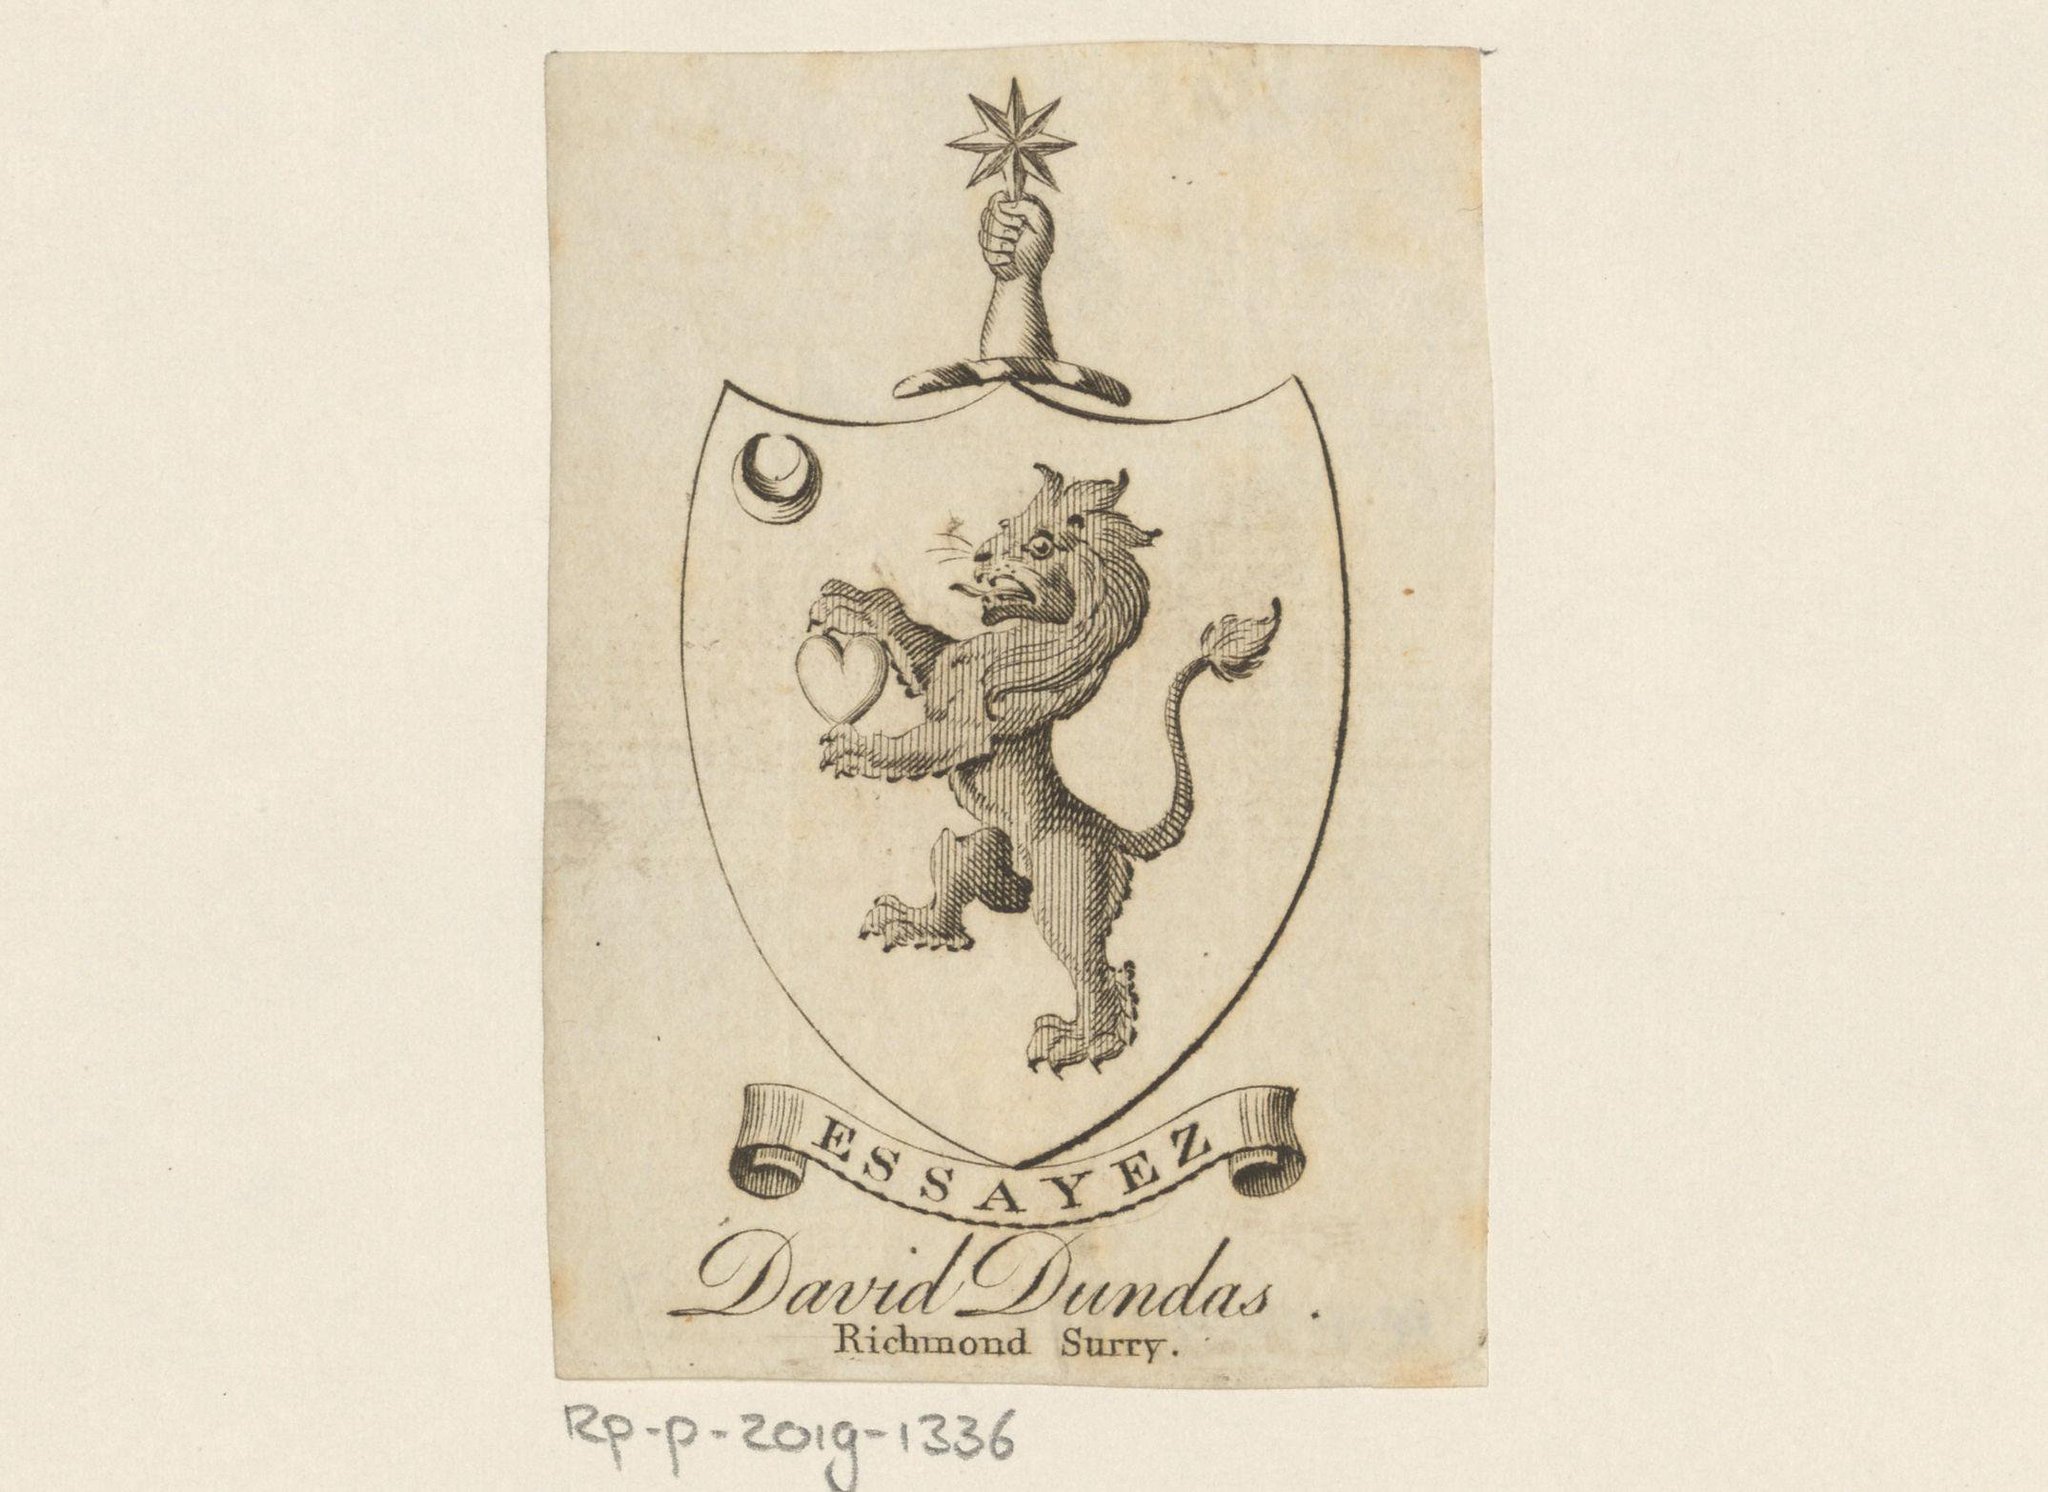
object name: bookplate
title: Ex libris van David Dundas, Richmond Surry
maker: Anonymous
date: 1759-1826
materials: paper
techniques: engraving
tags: armorial bearing, heraldry